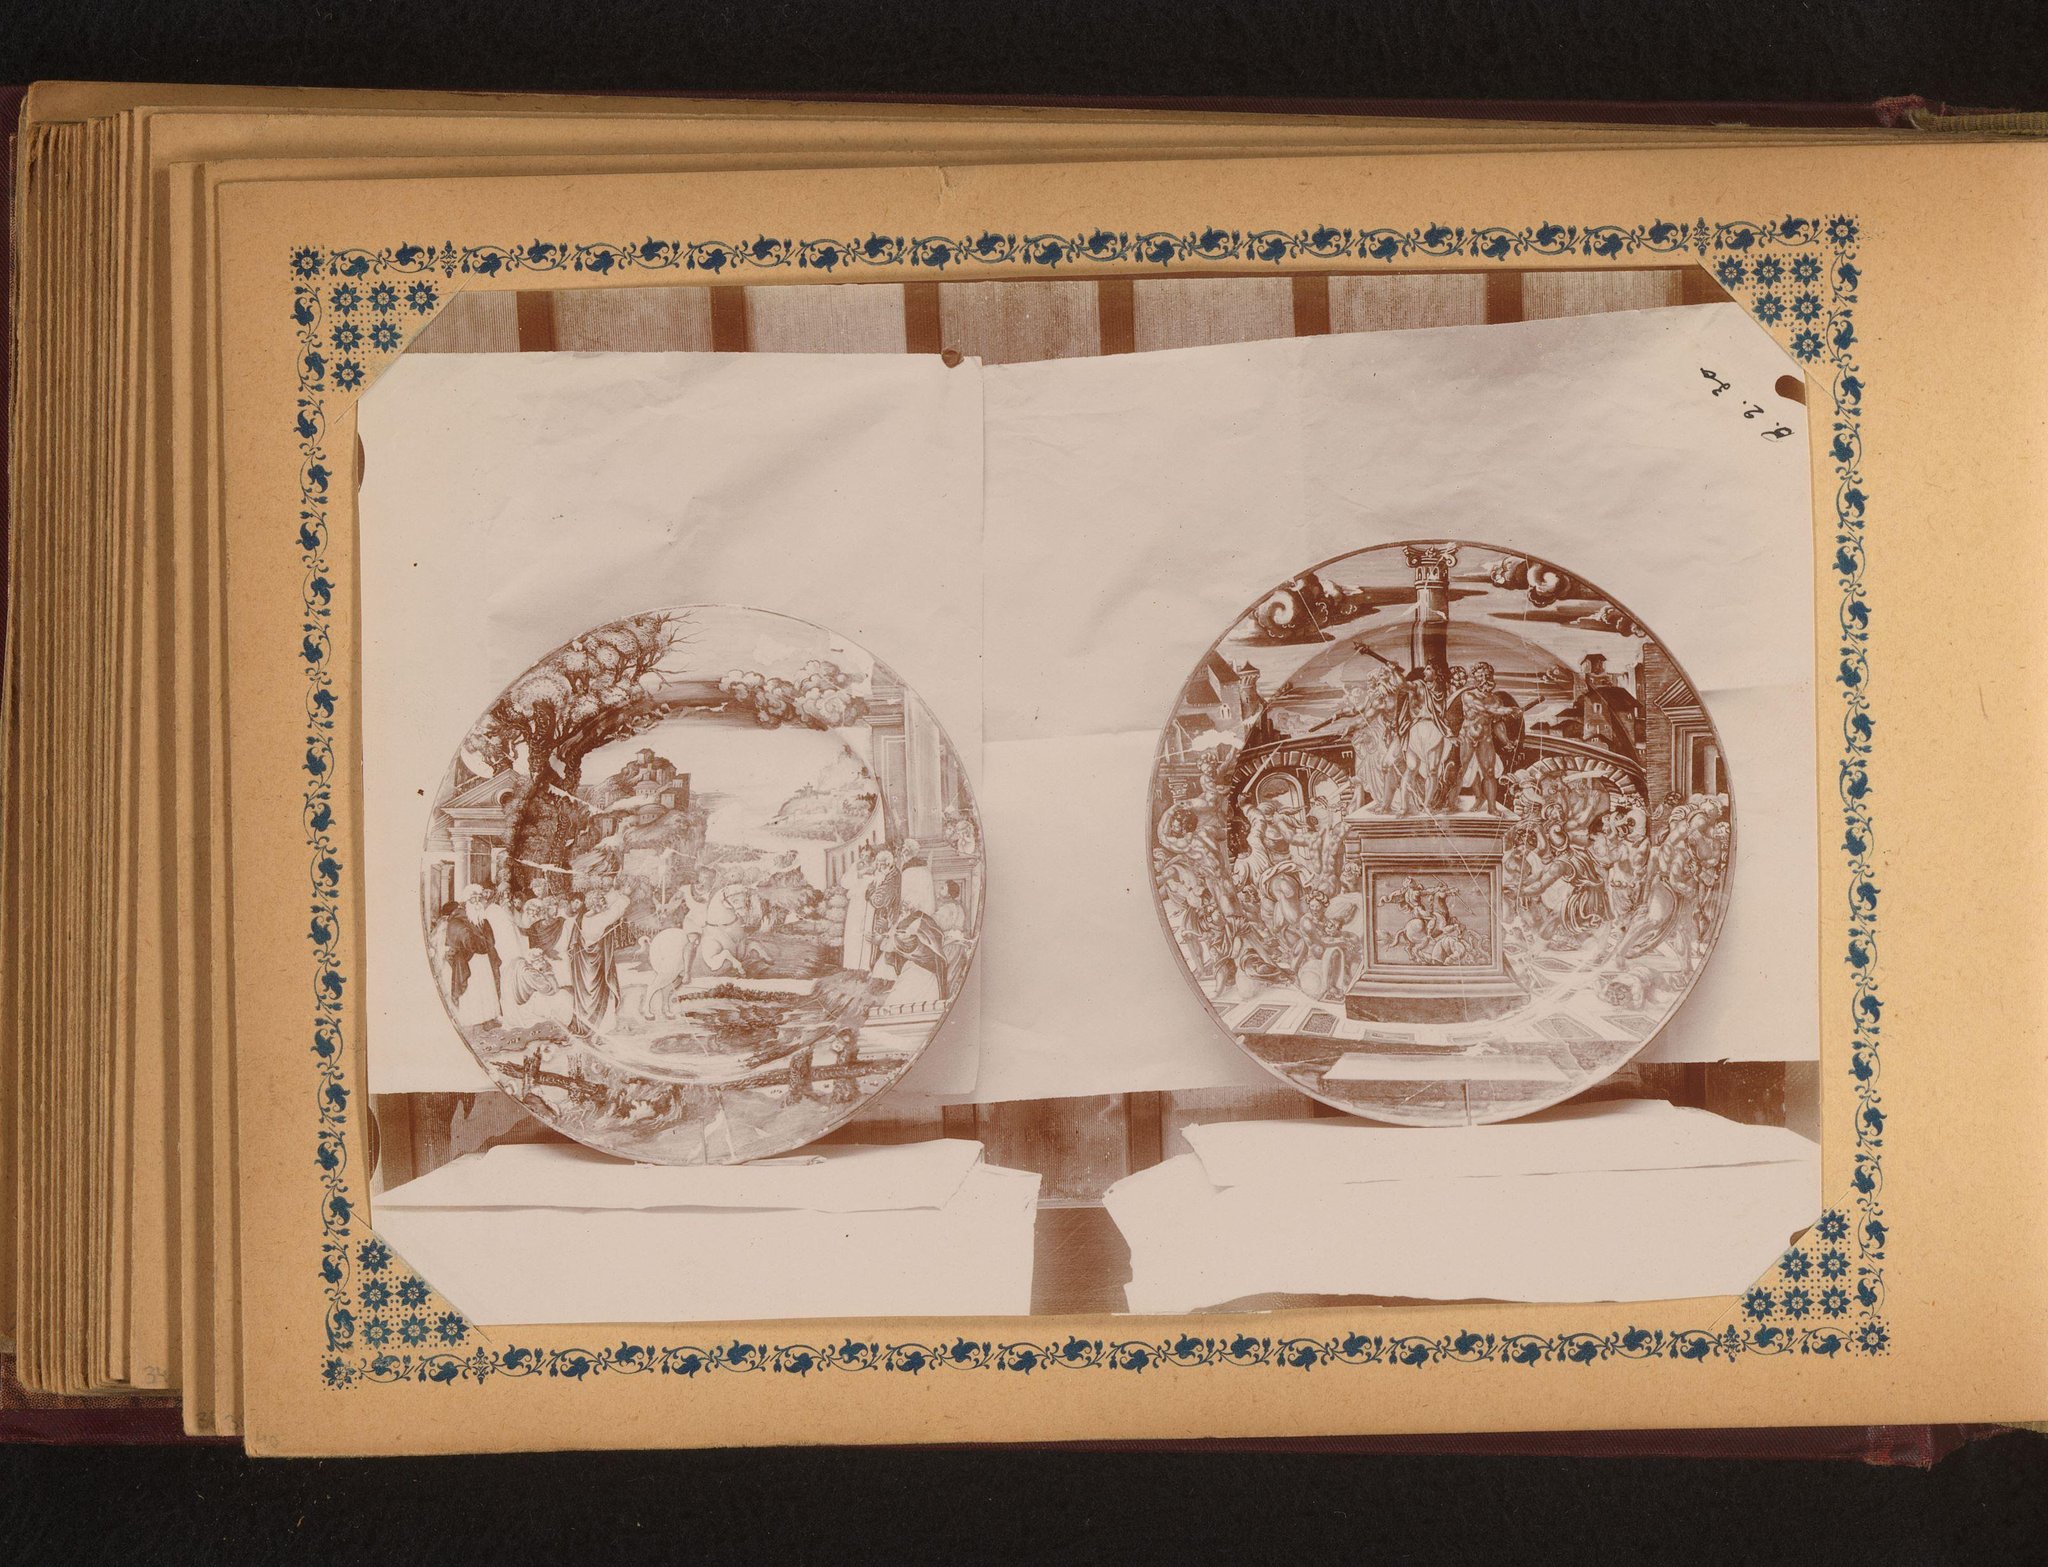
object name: album leaf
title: Twee borden beschilderd met voorstellingen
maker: Anonymous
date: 1880-1940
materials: cardboard, photographic support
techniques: gelatin silver print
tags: dish, plate, saucer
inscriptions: number: ‘B. 2. 30’